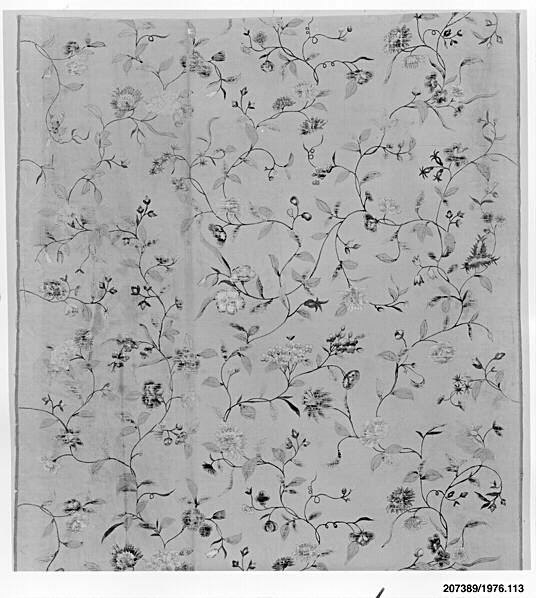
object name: length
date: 1701-1800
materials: silk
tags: flowers